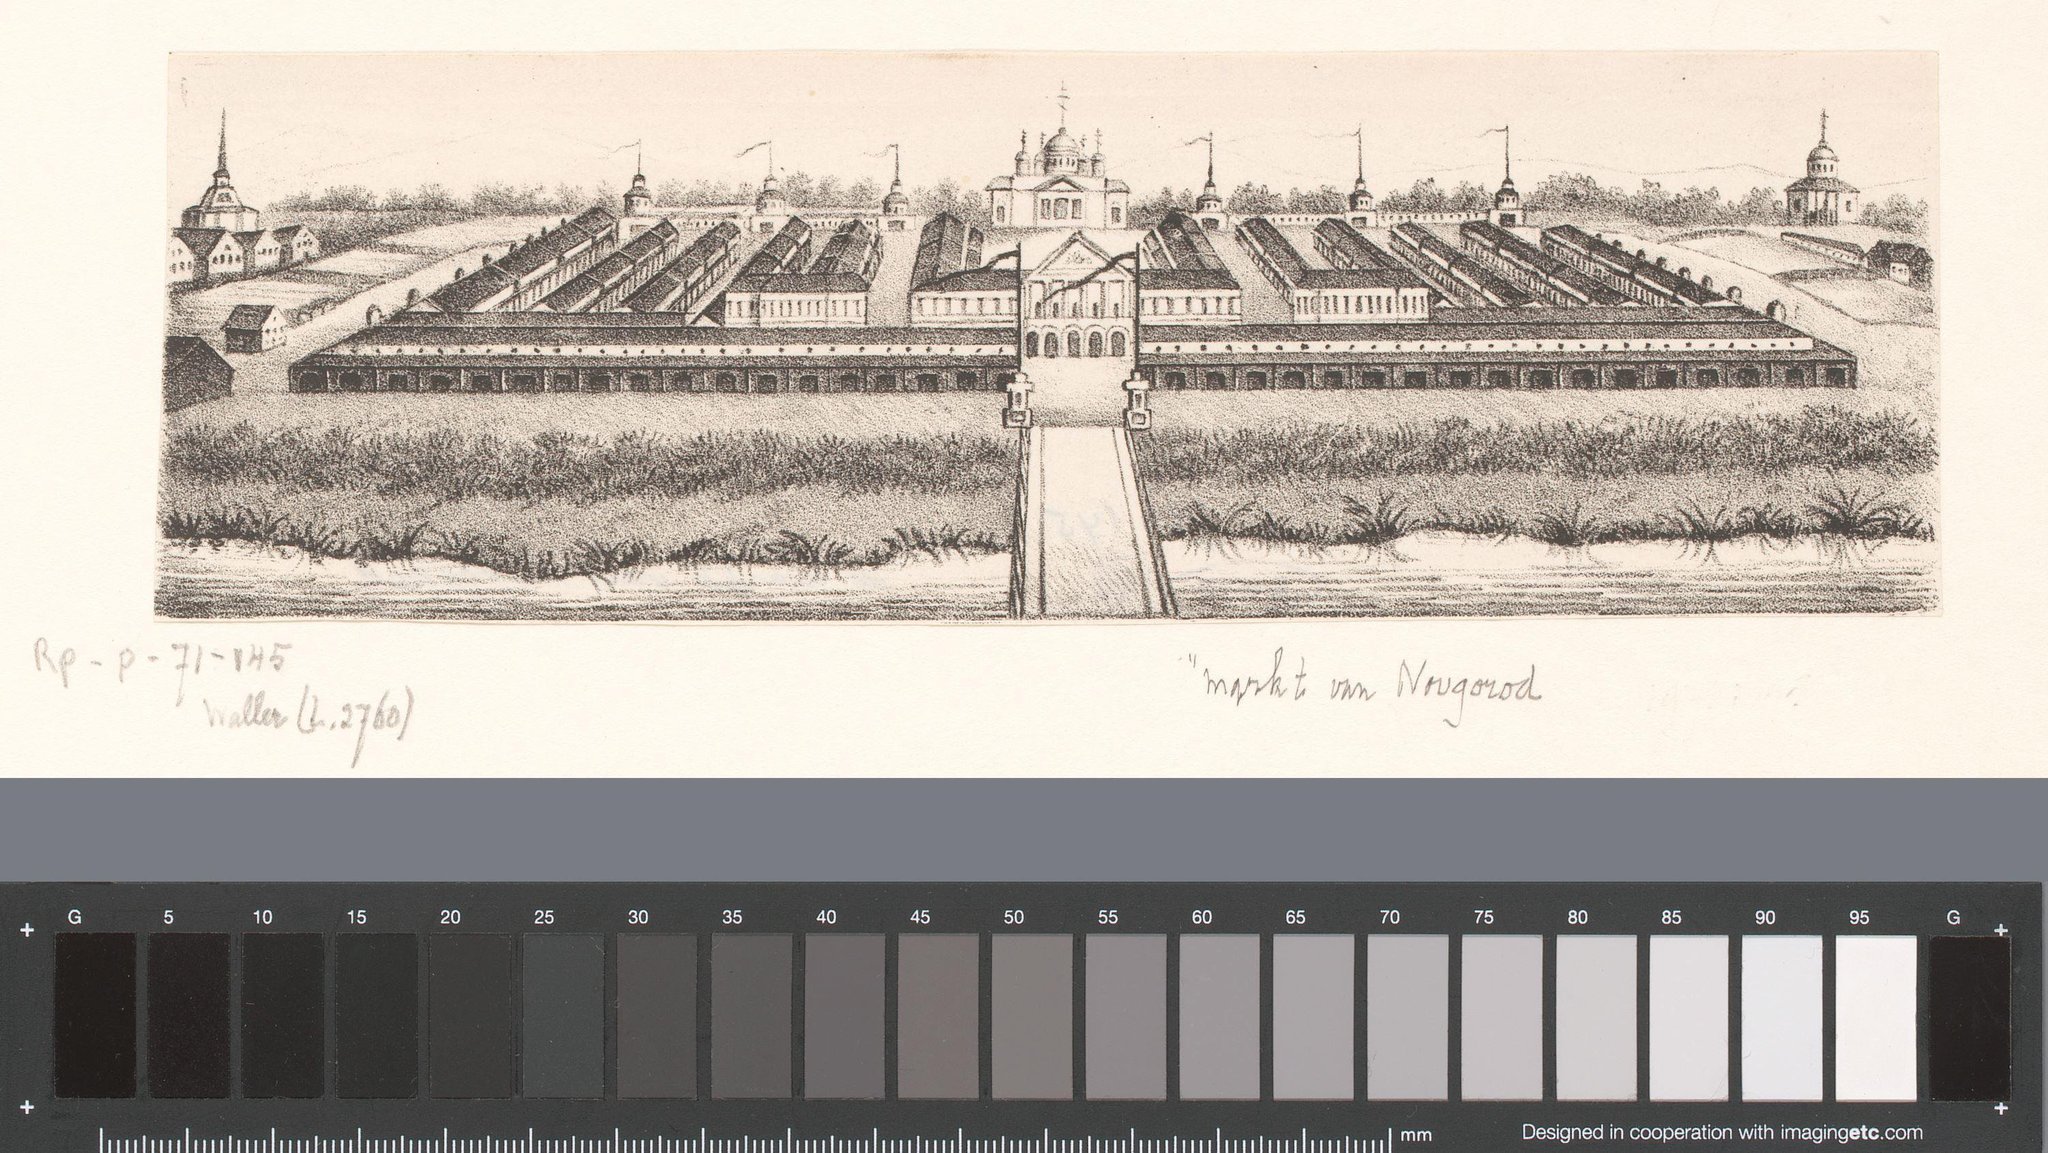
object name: print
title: Gezicht op de markt in Novgorod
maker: Anonymous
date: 1800-1899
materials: paper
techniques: lithograph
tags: market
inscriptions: collector's mark: Lugt 2760, collector's mark: Lugt 2228